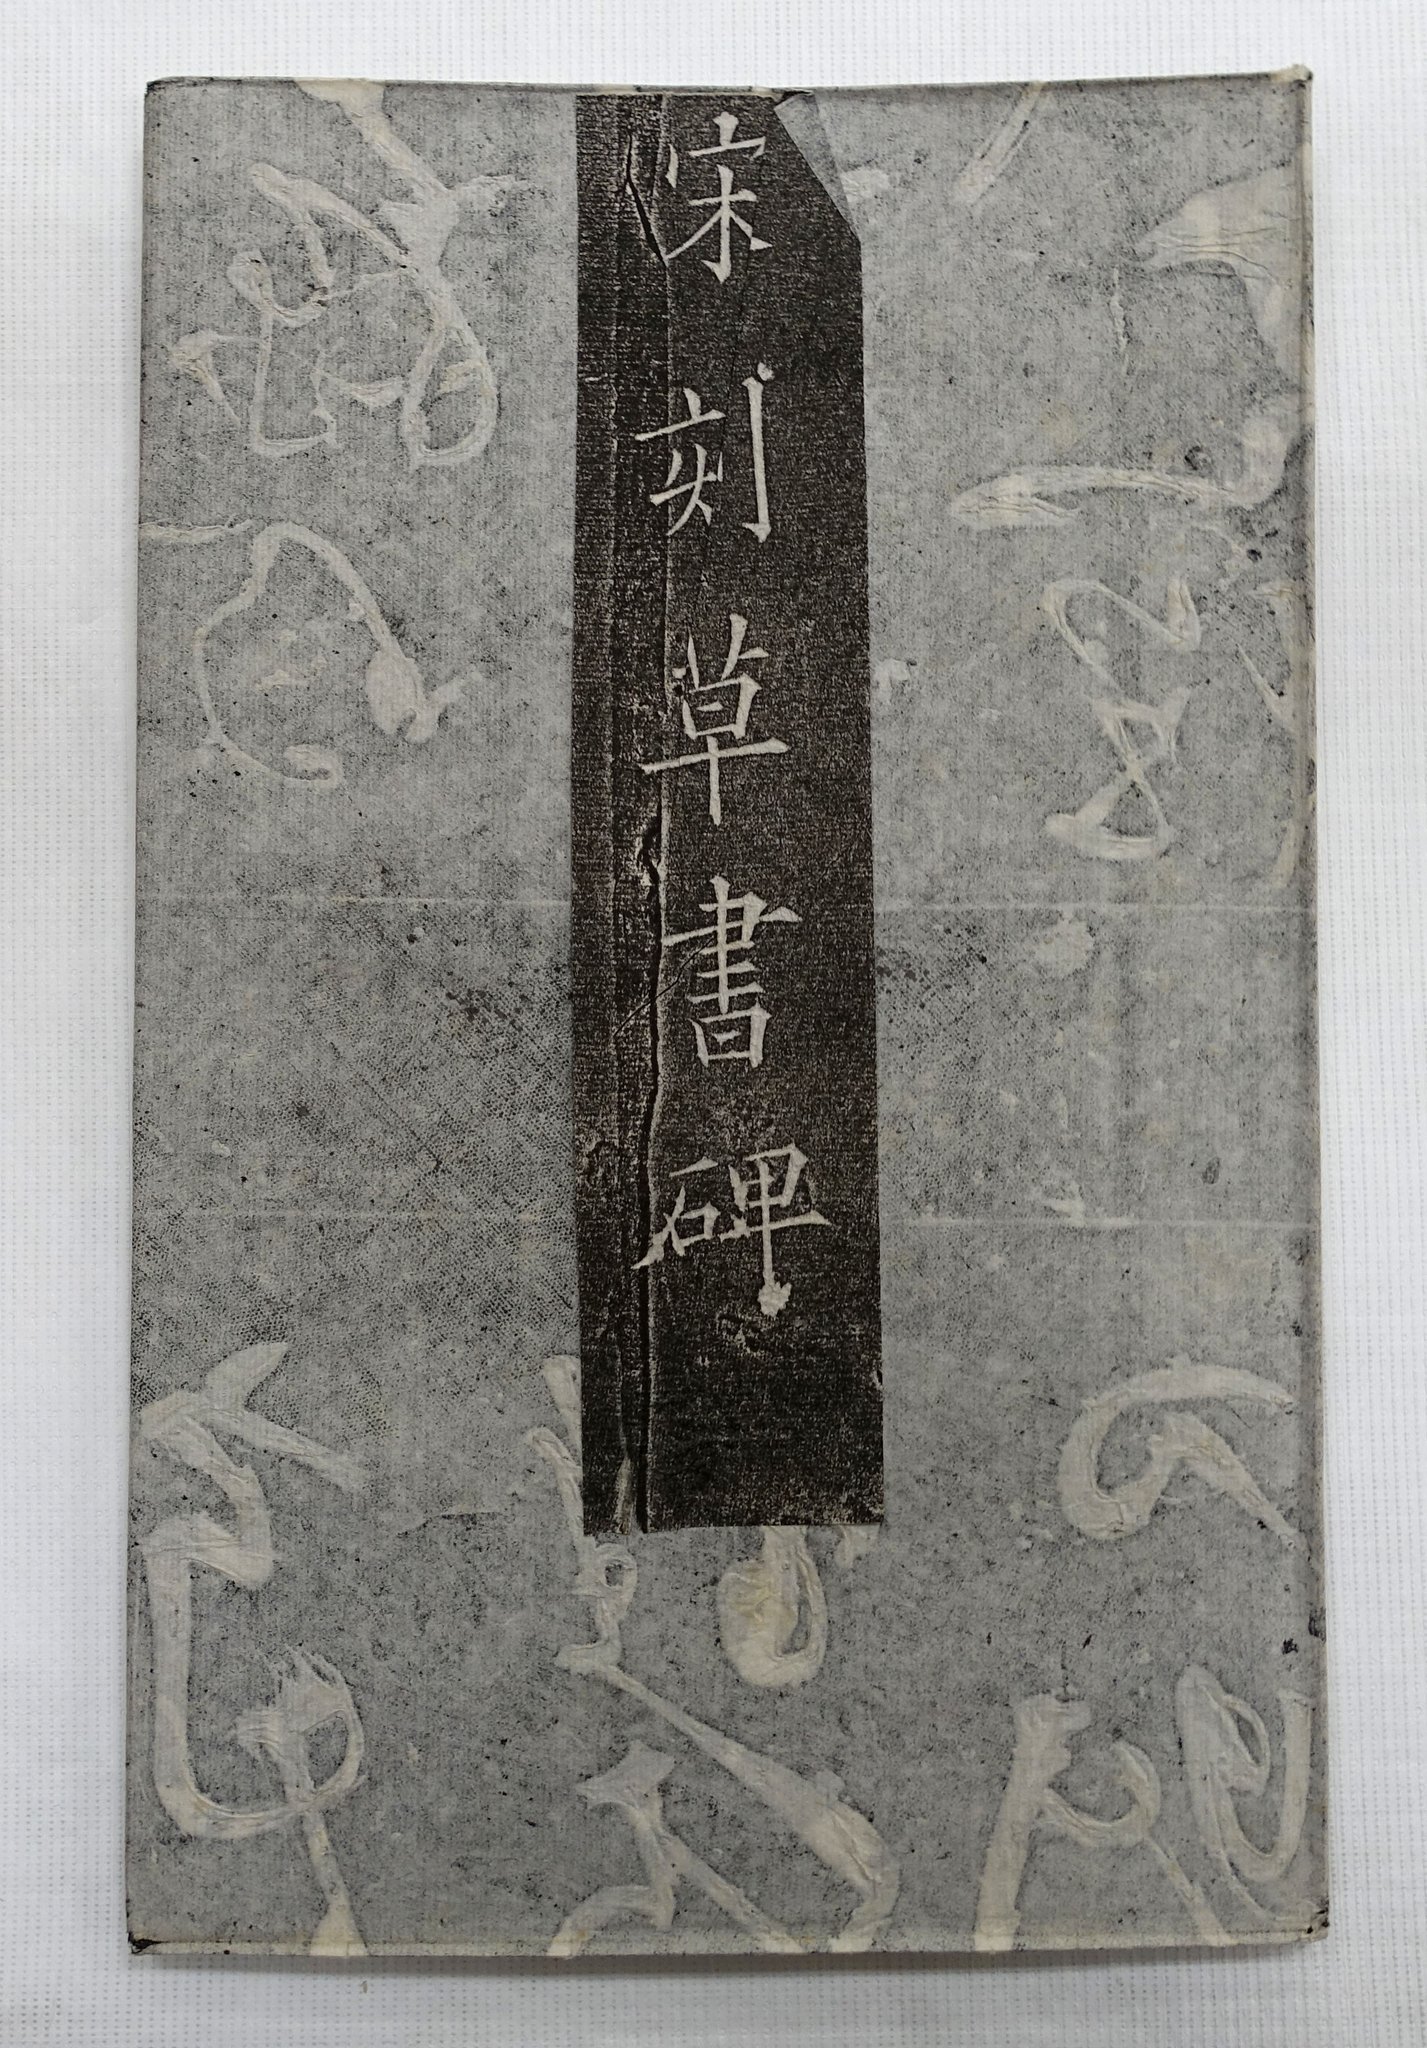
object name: rubbing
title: Cursive Calligraphy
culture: chinese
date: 1901-2000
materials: ink, paper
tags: calligraphy